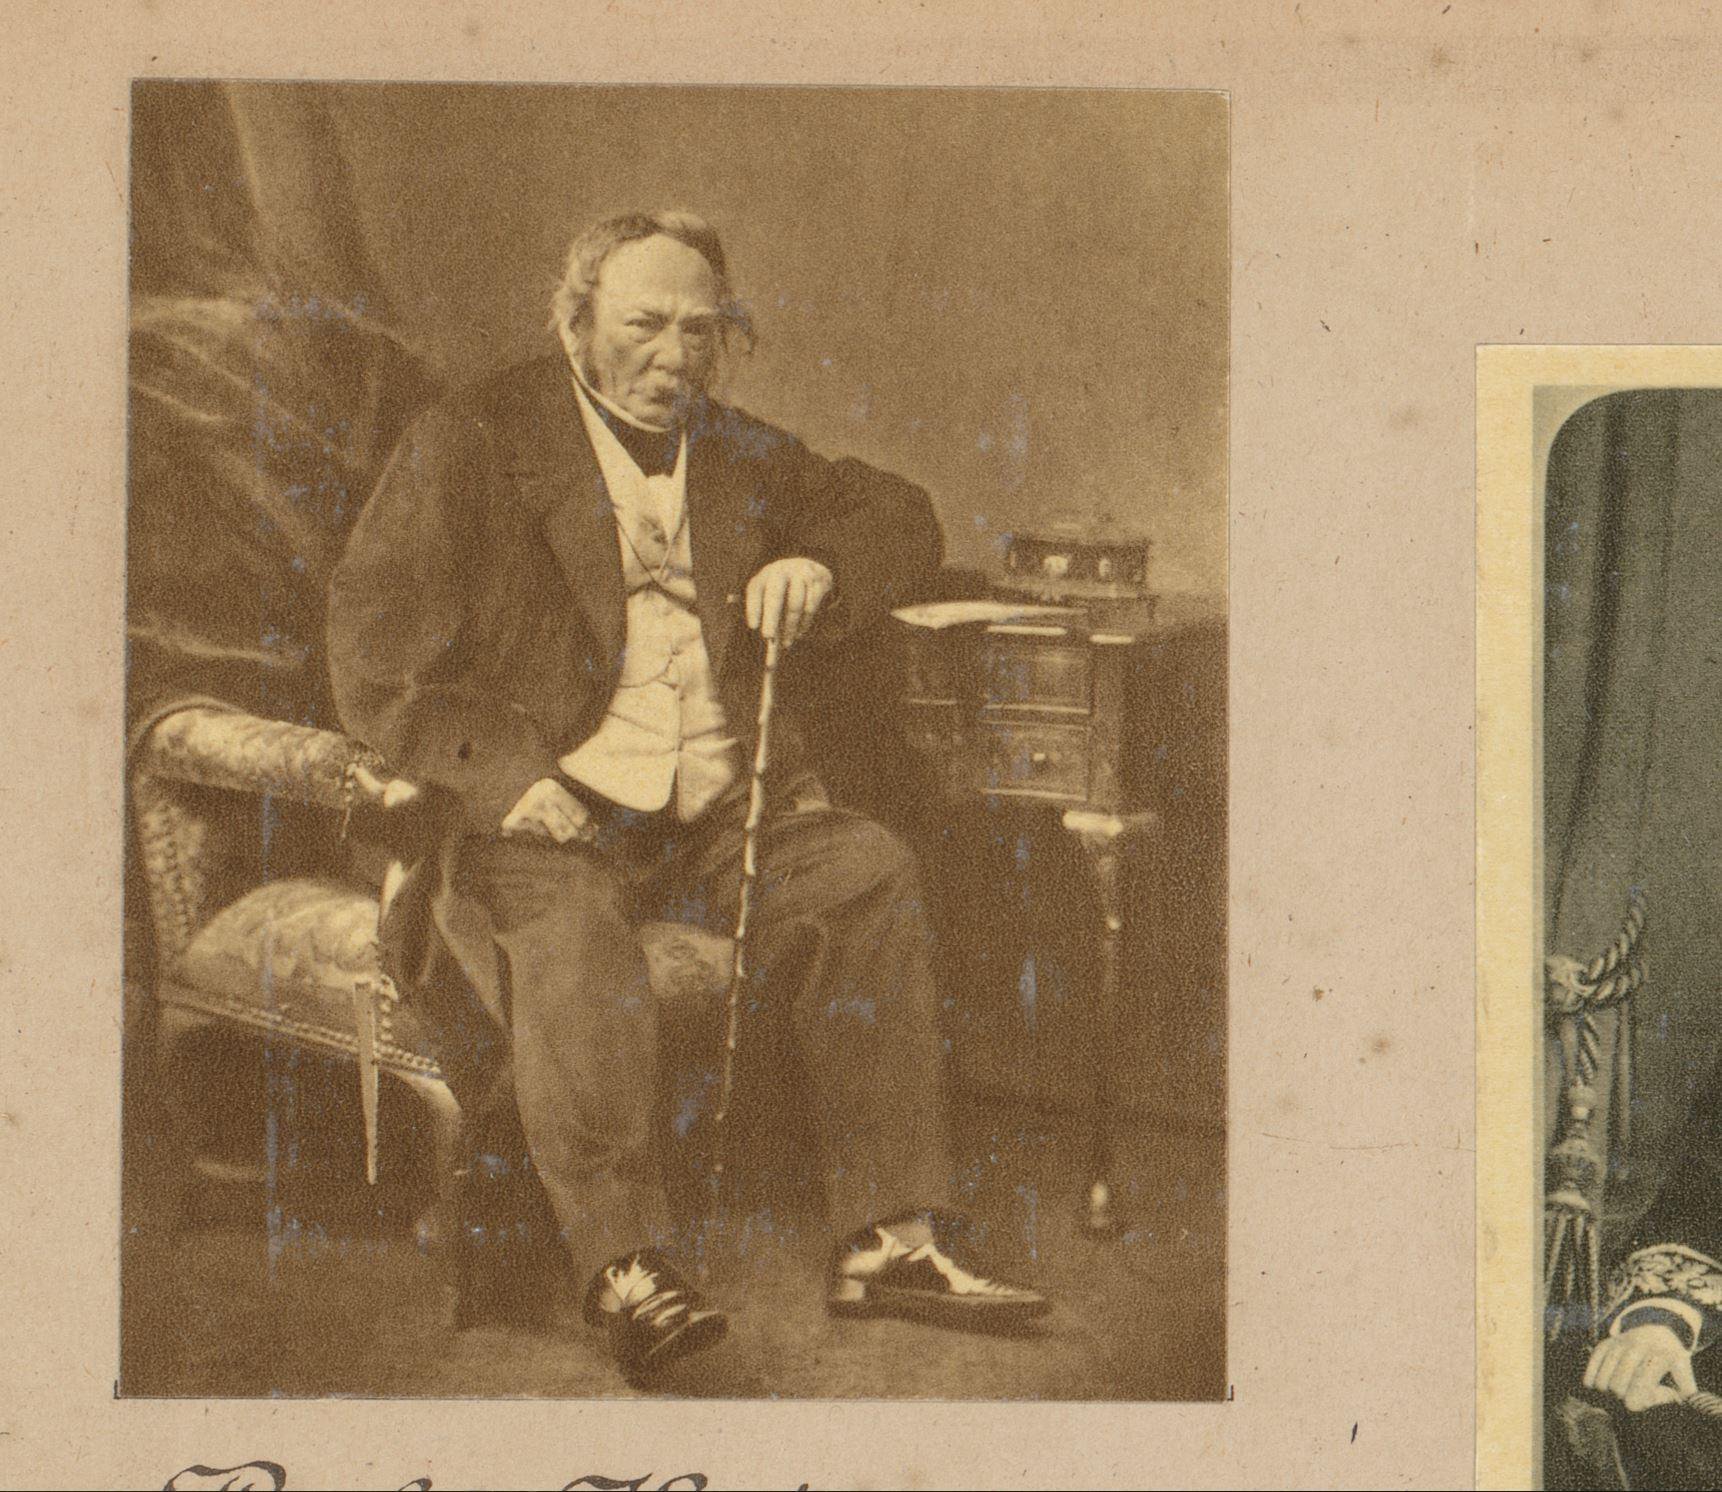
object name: album leaf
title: Paul de Kock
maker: Anonymous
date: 1870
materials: paper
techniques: rotogravure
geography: france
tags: paris, writer, poet, author, france